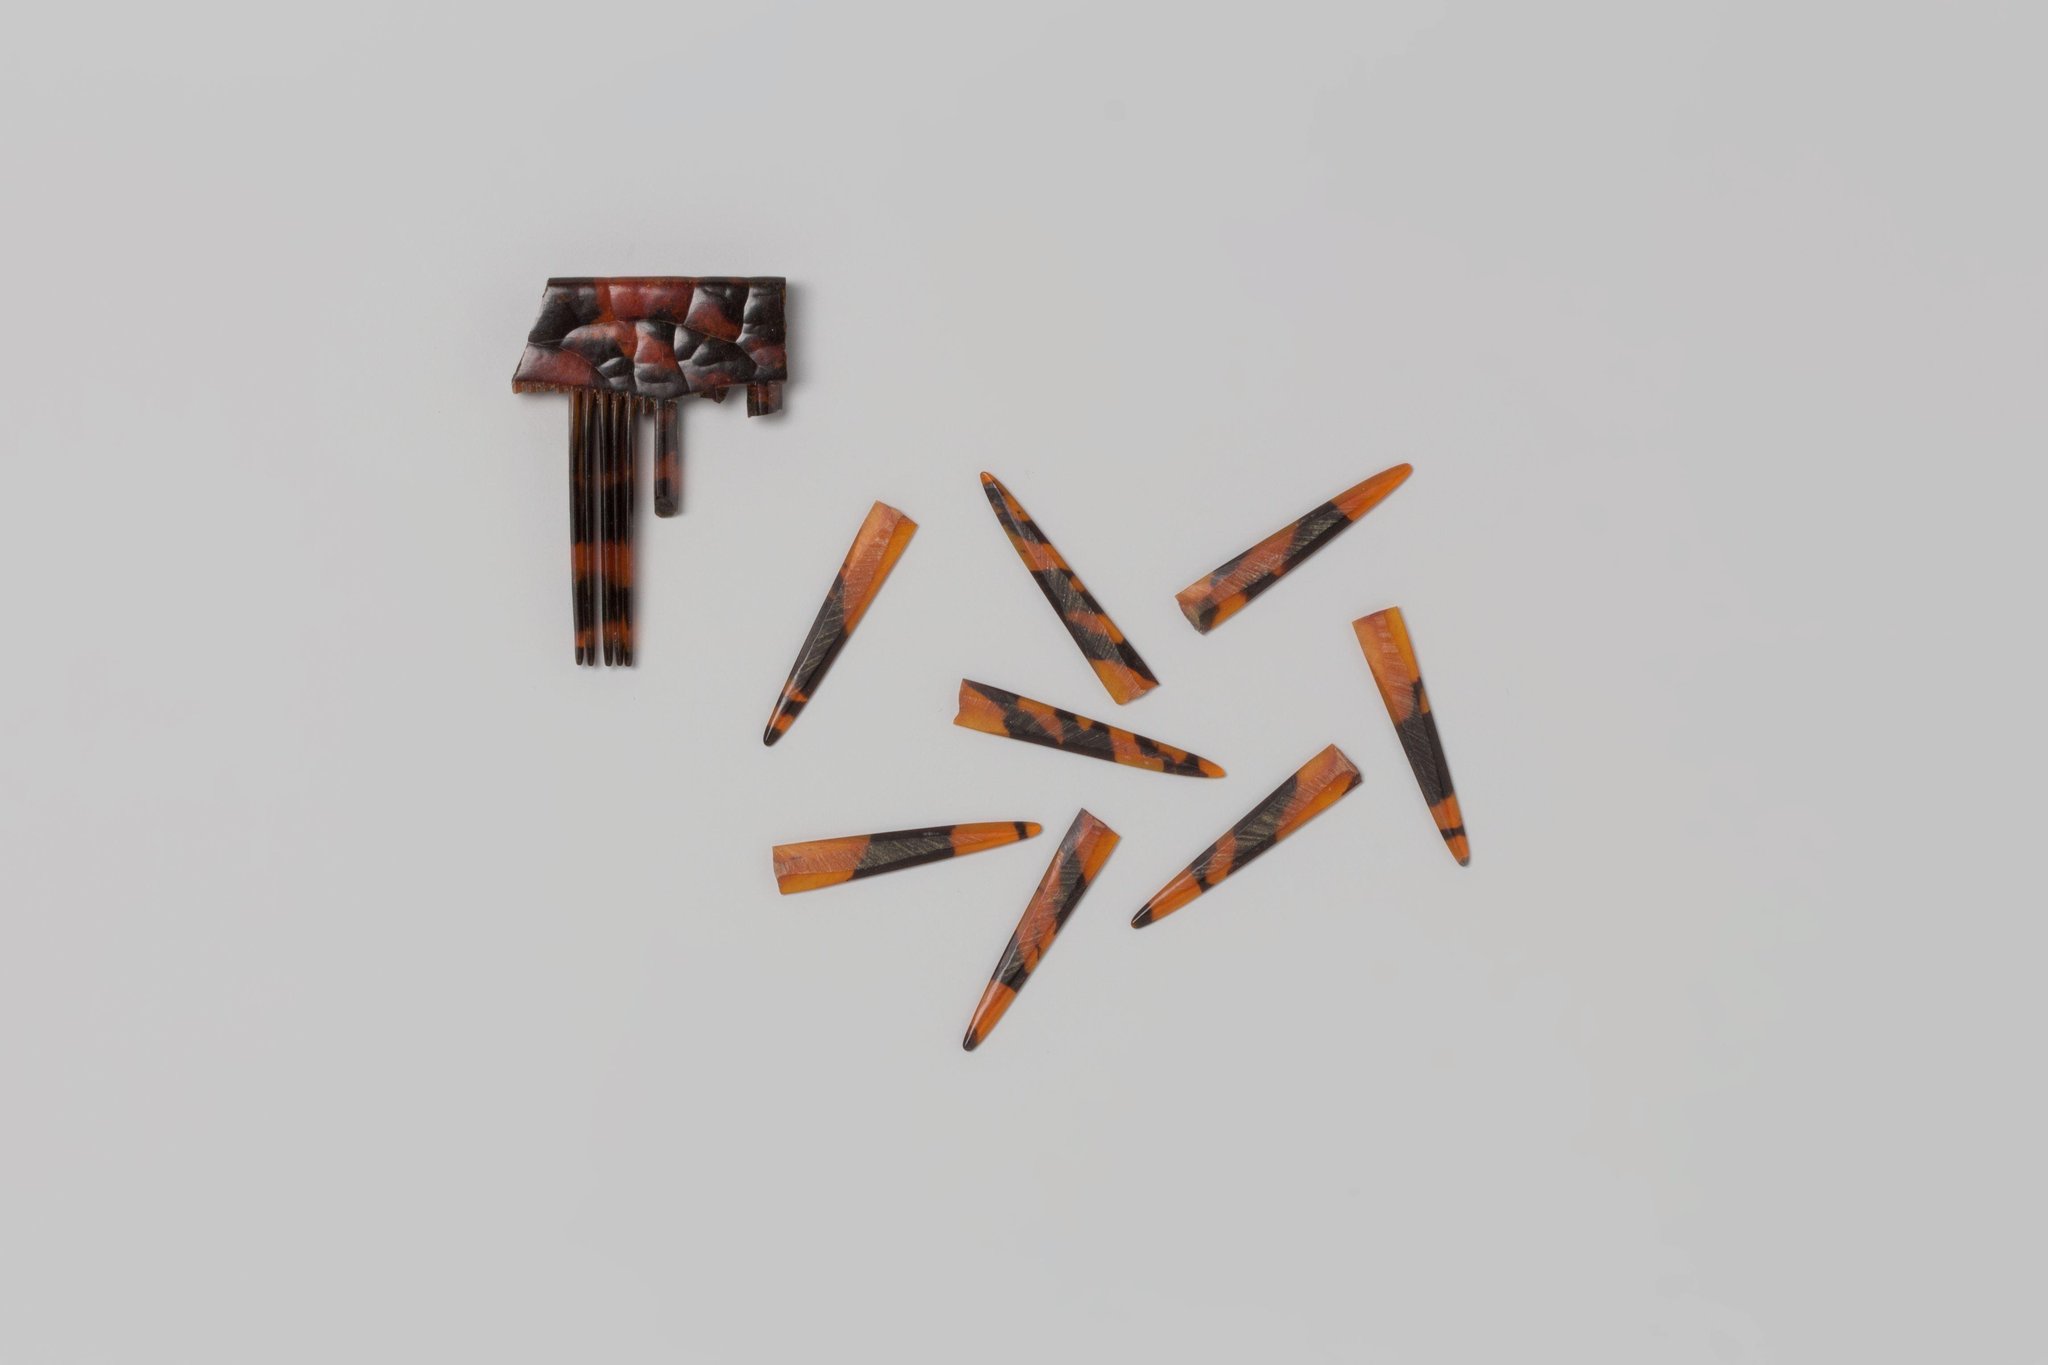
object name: comb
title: Haarkam van schildpad, recht model, half met fijne-, half met grove tanden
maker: Anonymous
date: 1800-1899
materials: shell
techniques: filing, polish, pressing, sawing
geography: netherlands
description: Haarkam, recht model, van schildpad, half met fijne-, half met grove tanden.